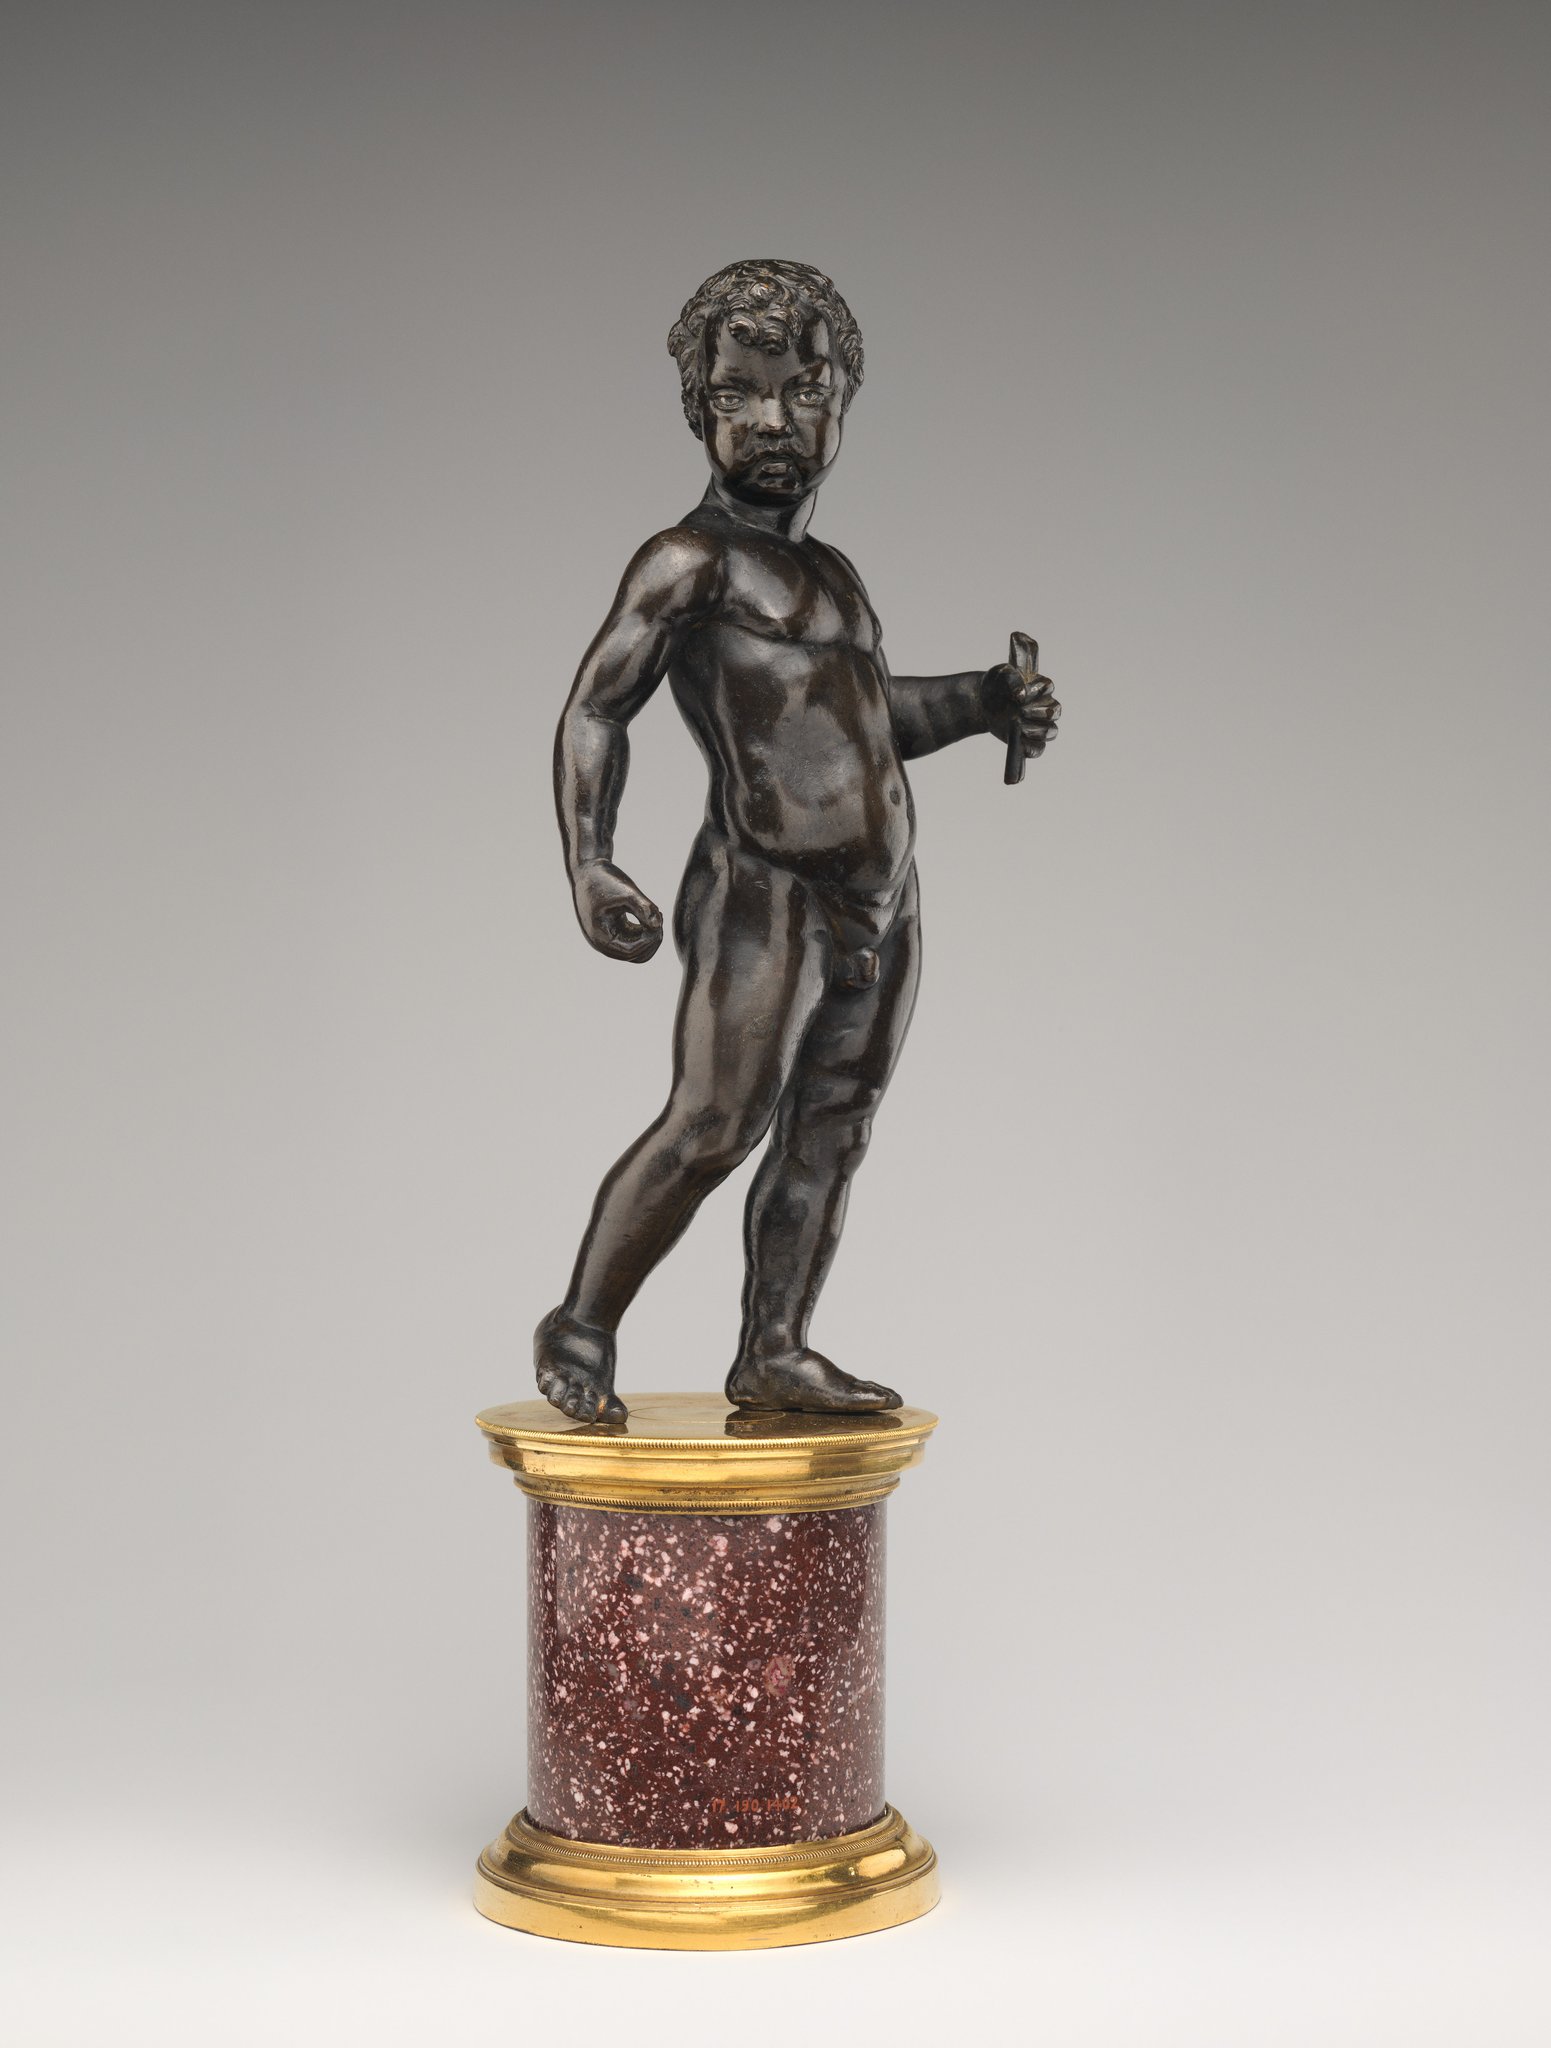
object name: statuette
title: Standing boy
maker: andrea mantegna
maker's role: artist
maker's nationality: italian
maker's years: 1431-1506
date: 1467-1533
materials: bronze, silver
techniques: inlay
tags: boys